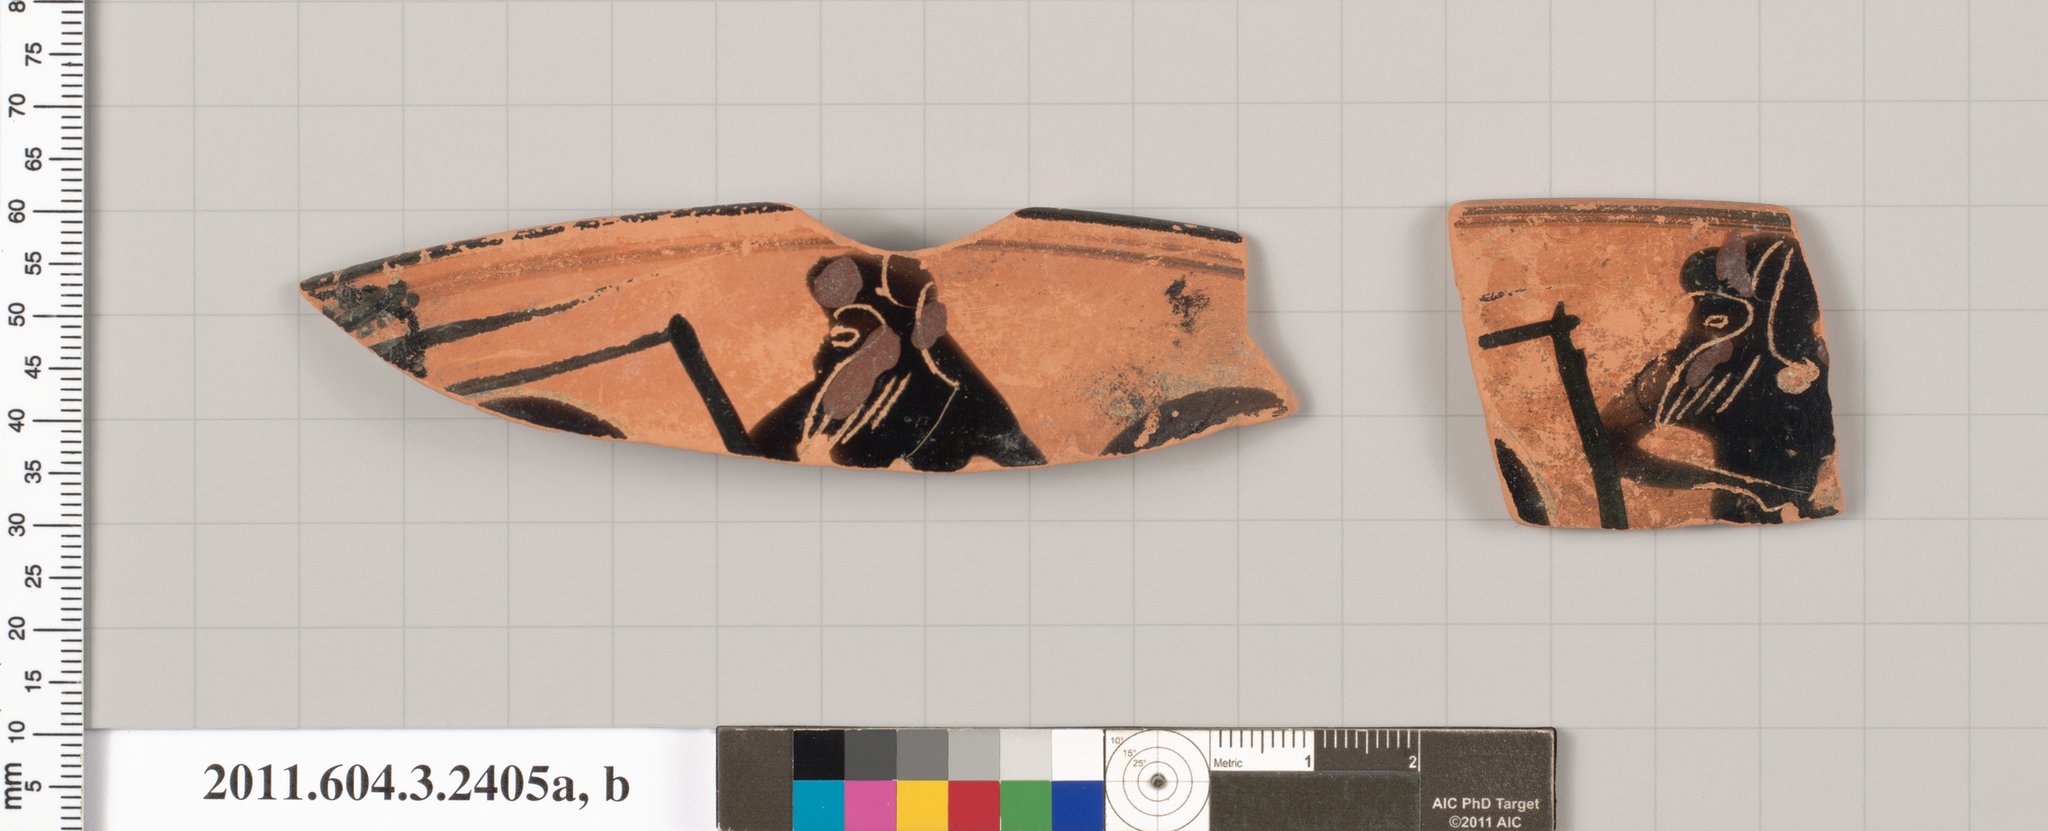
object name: kylix fragment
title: Terracotta rim fragments of a kylix: eye-cup (drinking cup)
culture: greek, attic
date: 525-501 BCE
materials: terracotta